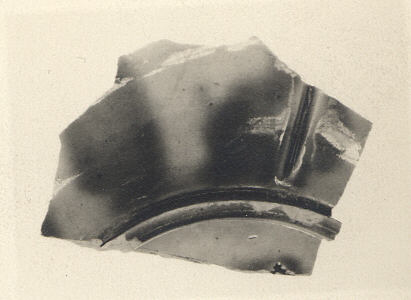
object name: fragment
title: Fragment of a Bowl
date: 801-1000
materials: porcelain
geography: china